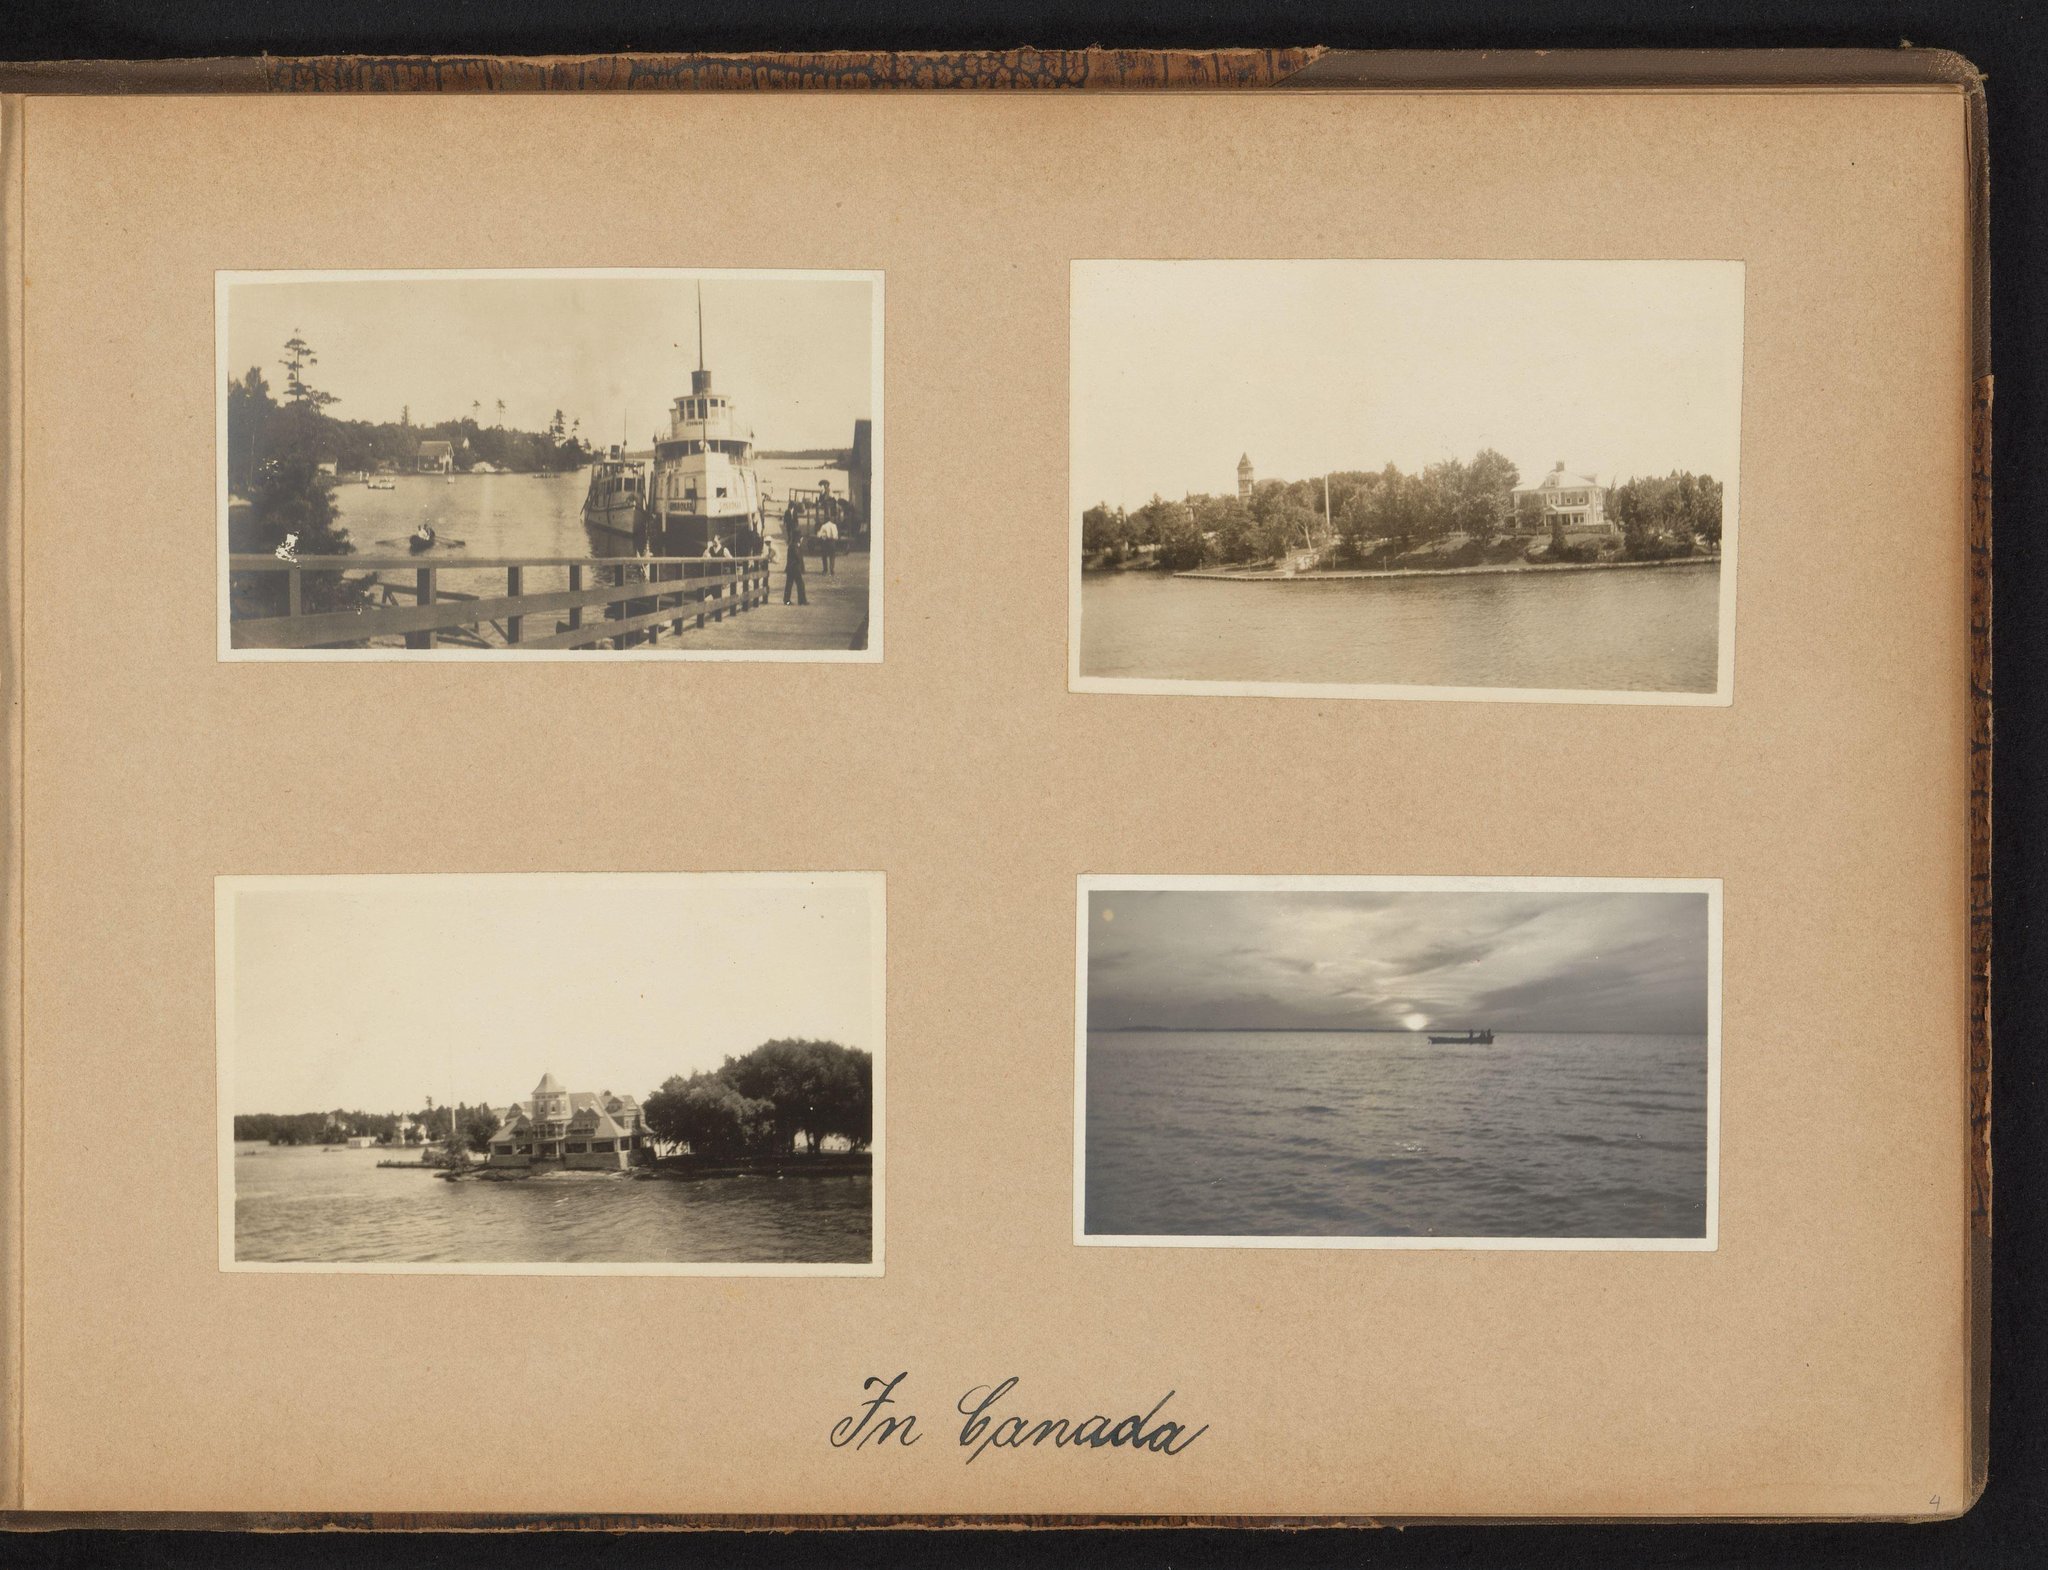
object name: photograph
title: In Canada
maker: willy moos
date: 1909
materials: paper, photographic support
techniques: gelatin silver print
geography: canada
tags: willy moos, river, rural housing, e.g. country-house, villa, cottage, steamship, motorship, canada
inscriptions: inscription: ‘In Canada’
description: Albumblad met vier foto's van gezichten aan het water in Canada. Onderdeel van het fotoalbum van een reis van Willy Moos naar Canada en de Verenigde Staten in 1909.